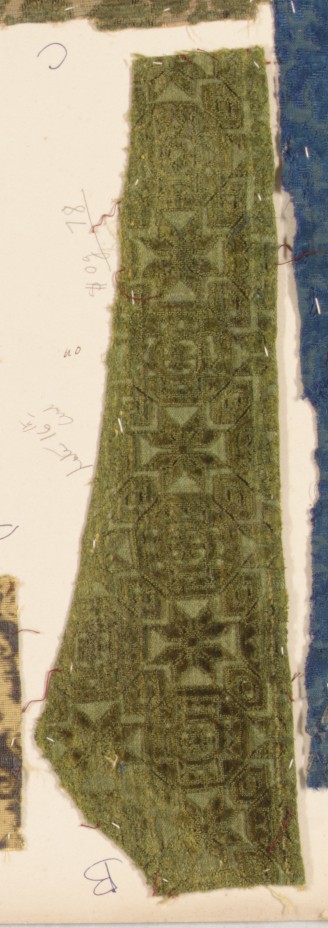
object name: fragment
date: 1601-1700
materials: silk